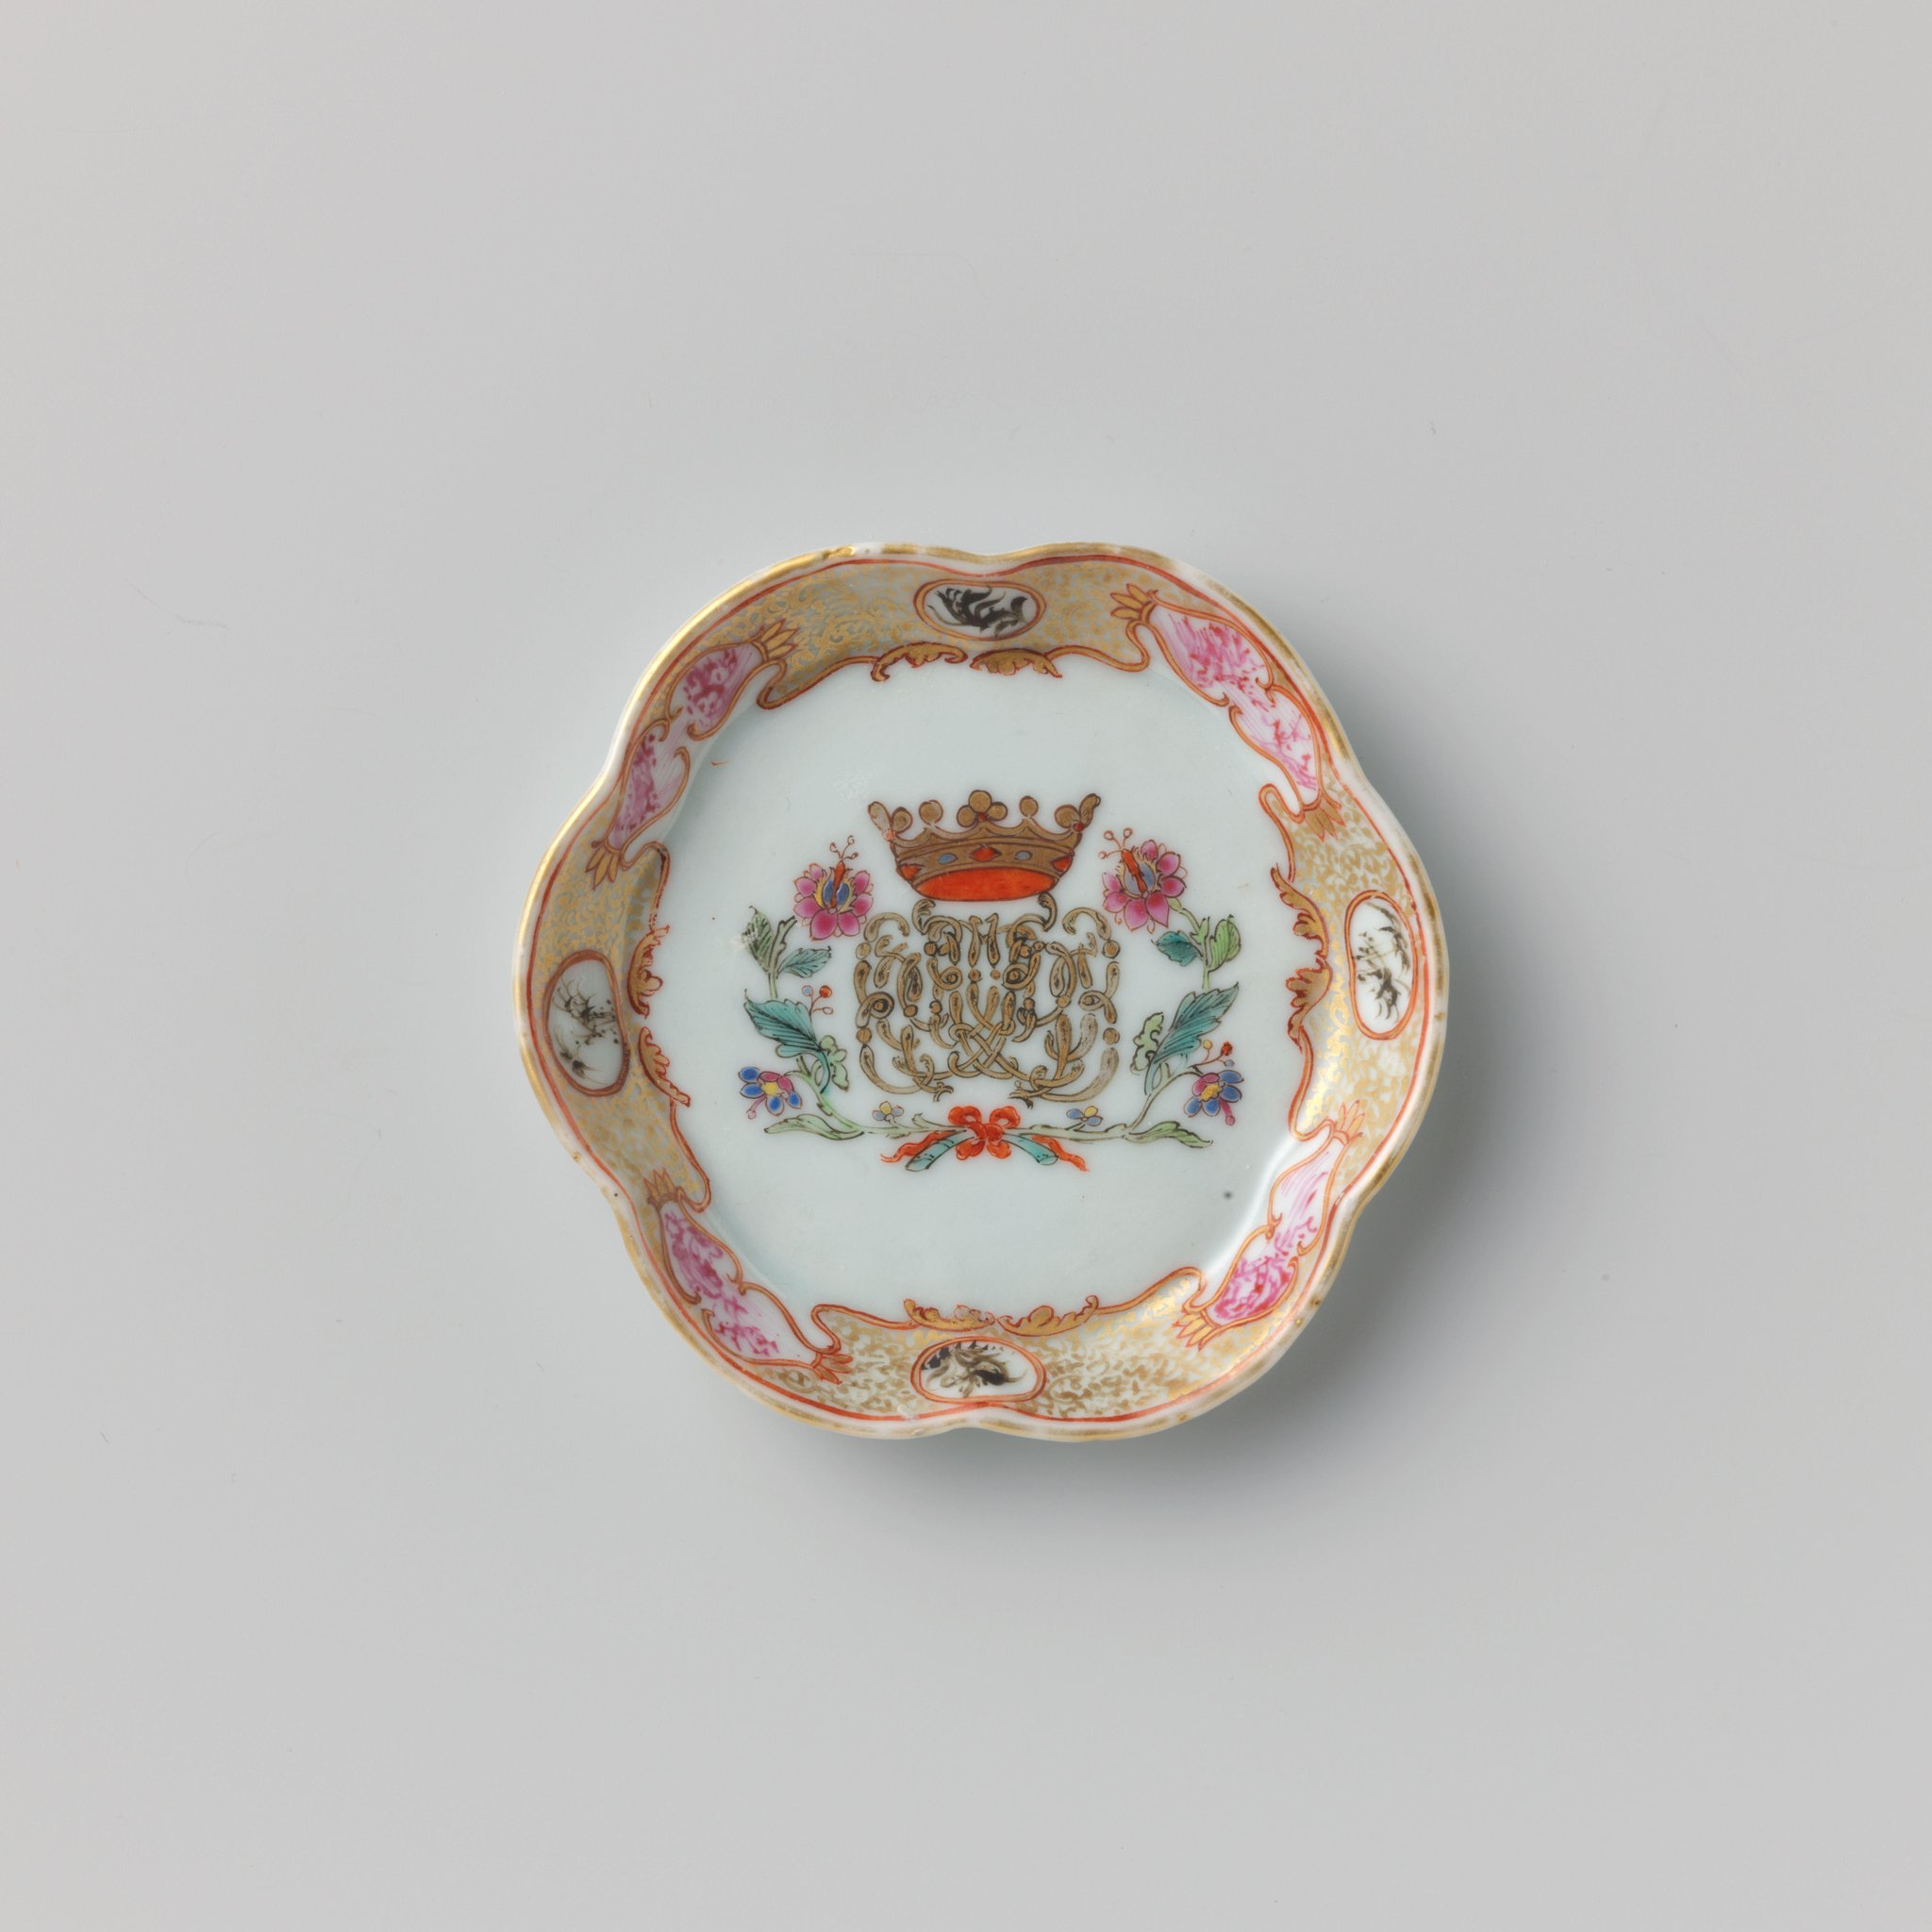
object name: pattipan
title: Teapot stand with a crowned, illegible monogram surrounded by two flower sprays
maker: Anonymous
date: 1750-1774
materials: glaze, gold, paint, porcelain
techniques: firing, gilding, turning, vitrification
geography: china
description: Pattipan van porselein met zesmaal gelobde wand, beschilderd op het glazuur in blauw, rood, roze, groen, geel, zwart en goud. Op het plat een gekroond, onleesbaar monogram omringd door twee bloemtakken; de wand met bloemranken met daarin uitgespaard vier cartouches met een landschap en vier medaillons met planten. Europese voorstelling in emailkleuren.